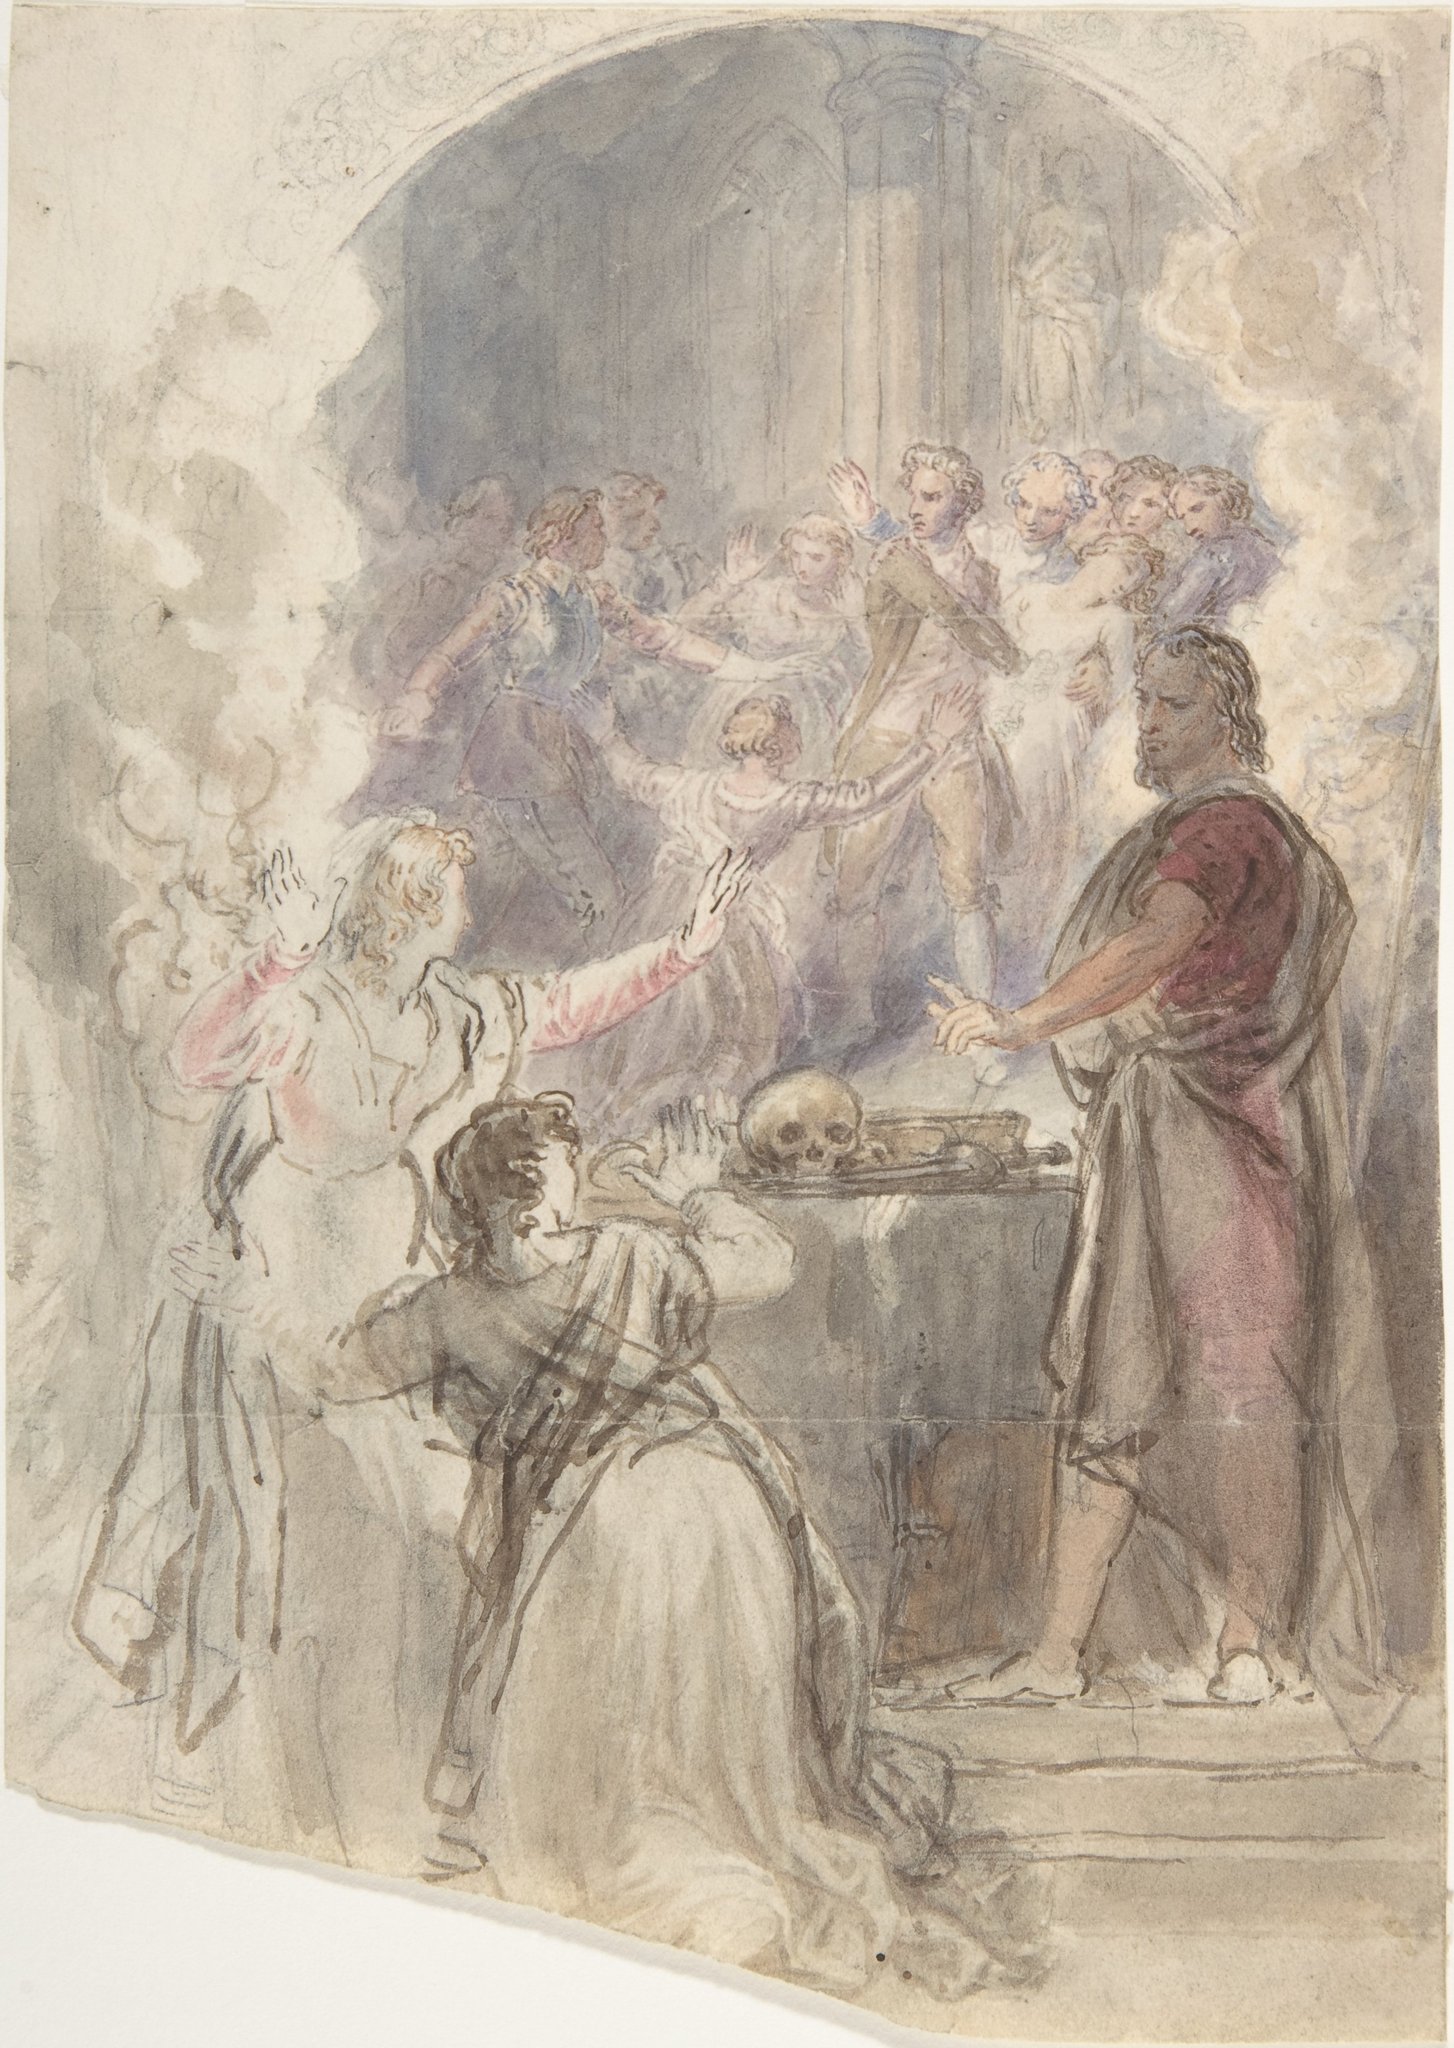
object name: drawing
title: Scene from "My Aunt Margaret's Mirror" (Keepsake Story by Sir Walter Scott)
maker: john william wright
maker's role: artist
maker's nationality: british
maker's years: 1802-1848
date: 1828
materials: watercolor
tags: skulls,men,women